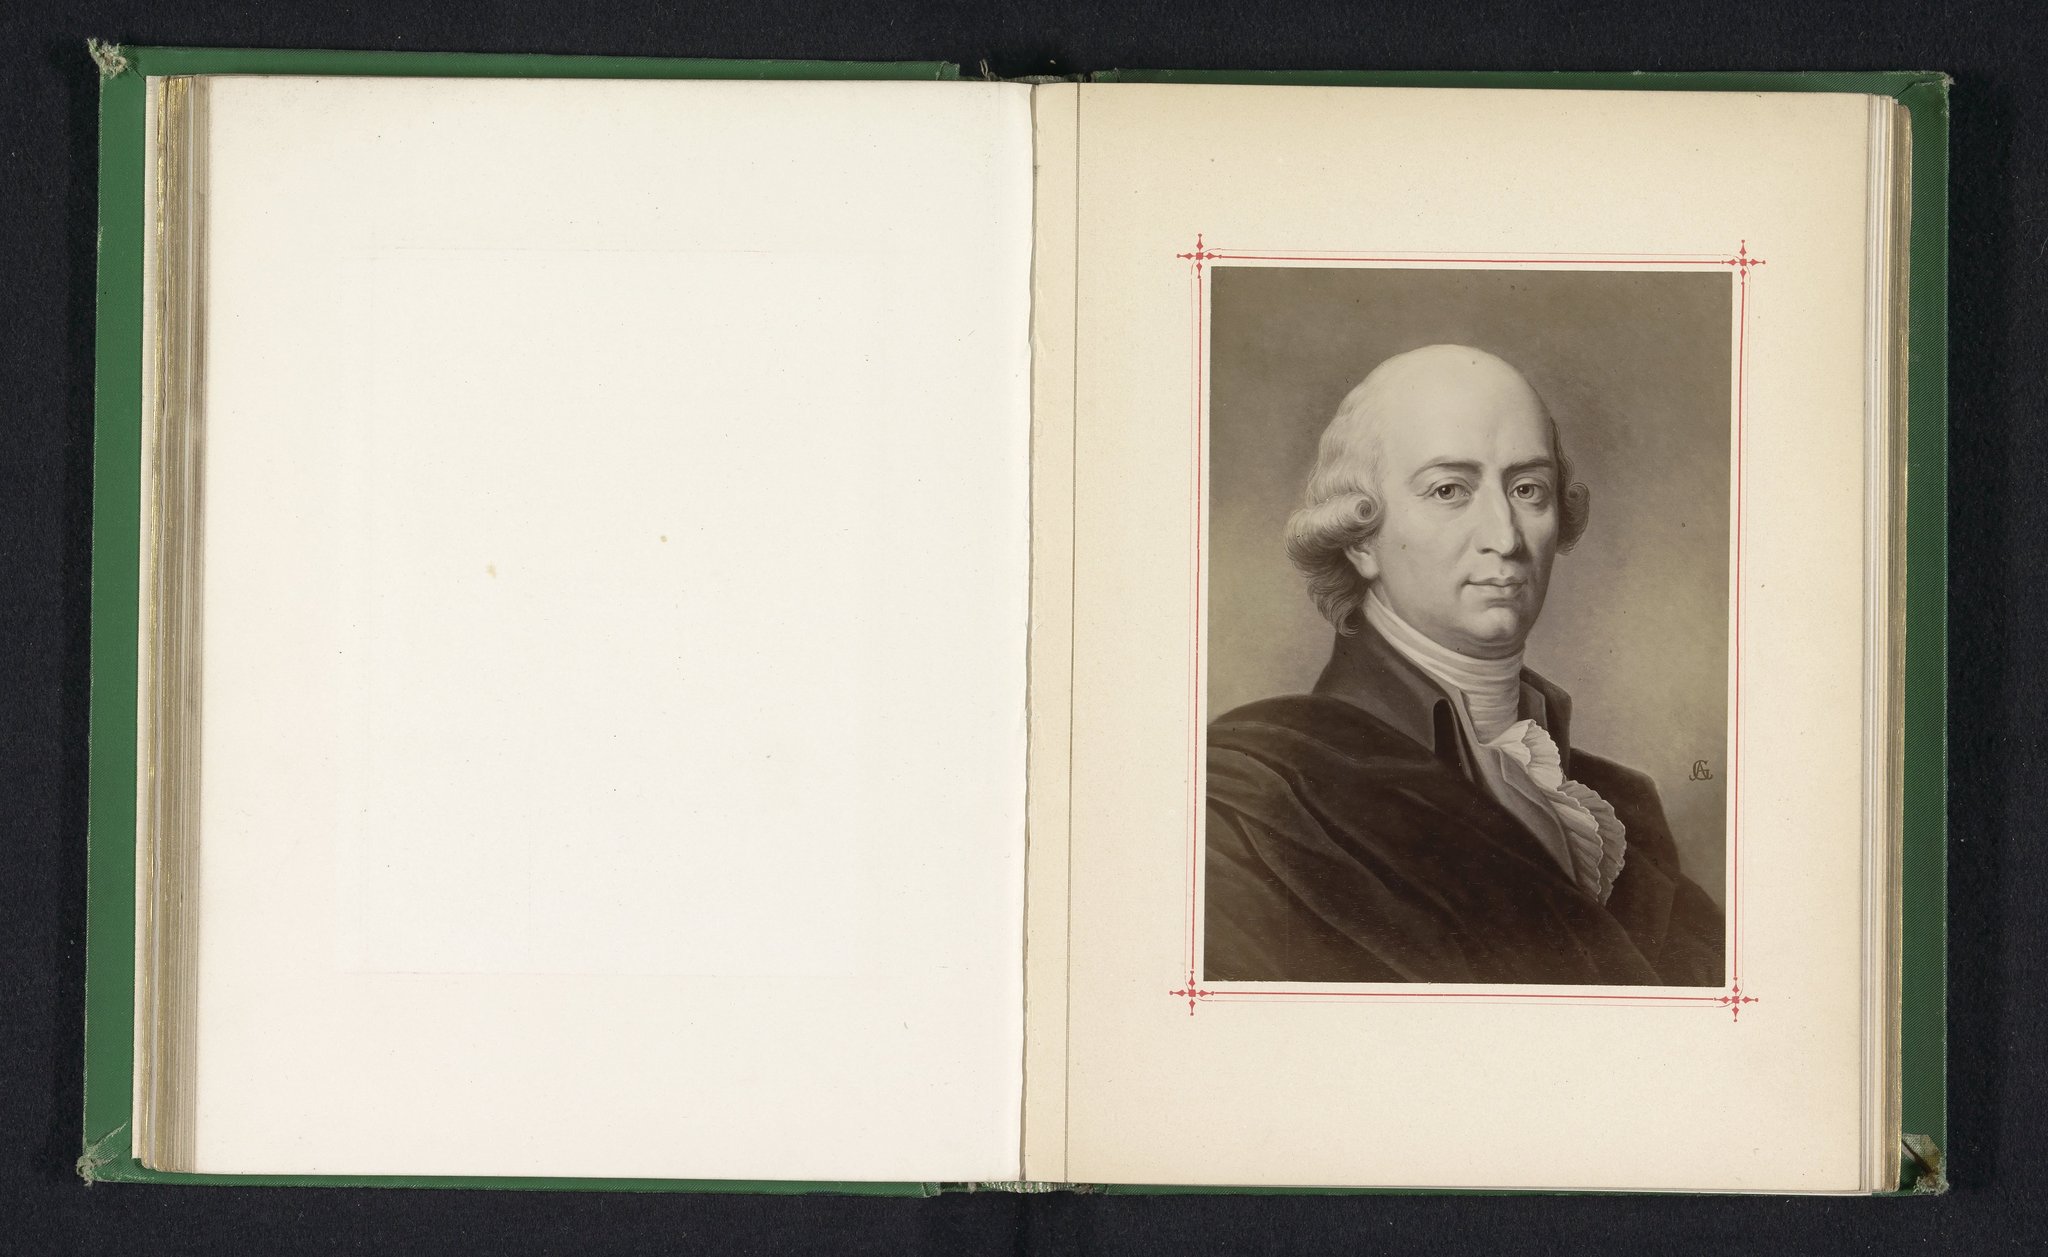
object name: page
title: Fotoreproductie van een portret van Johann Gottfried von Herder door vermoedelijk Albert Gräfle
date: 1868-1878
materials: photographic support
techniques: albumen print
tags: writer, poet, author